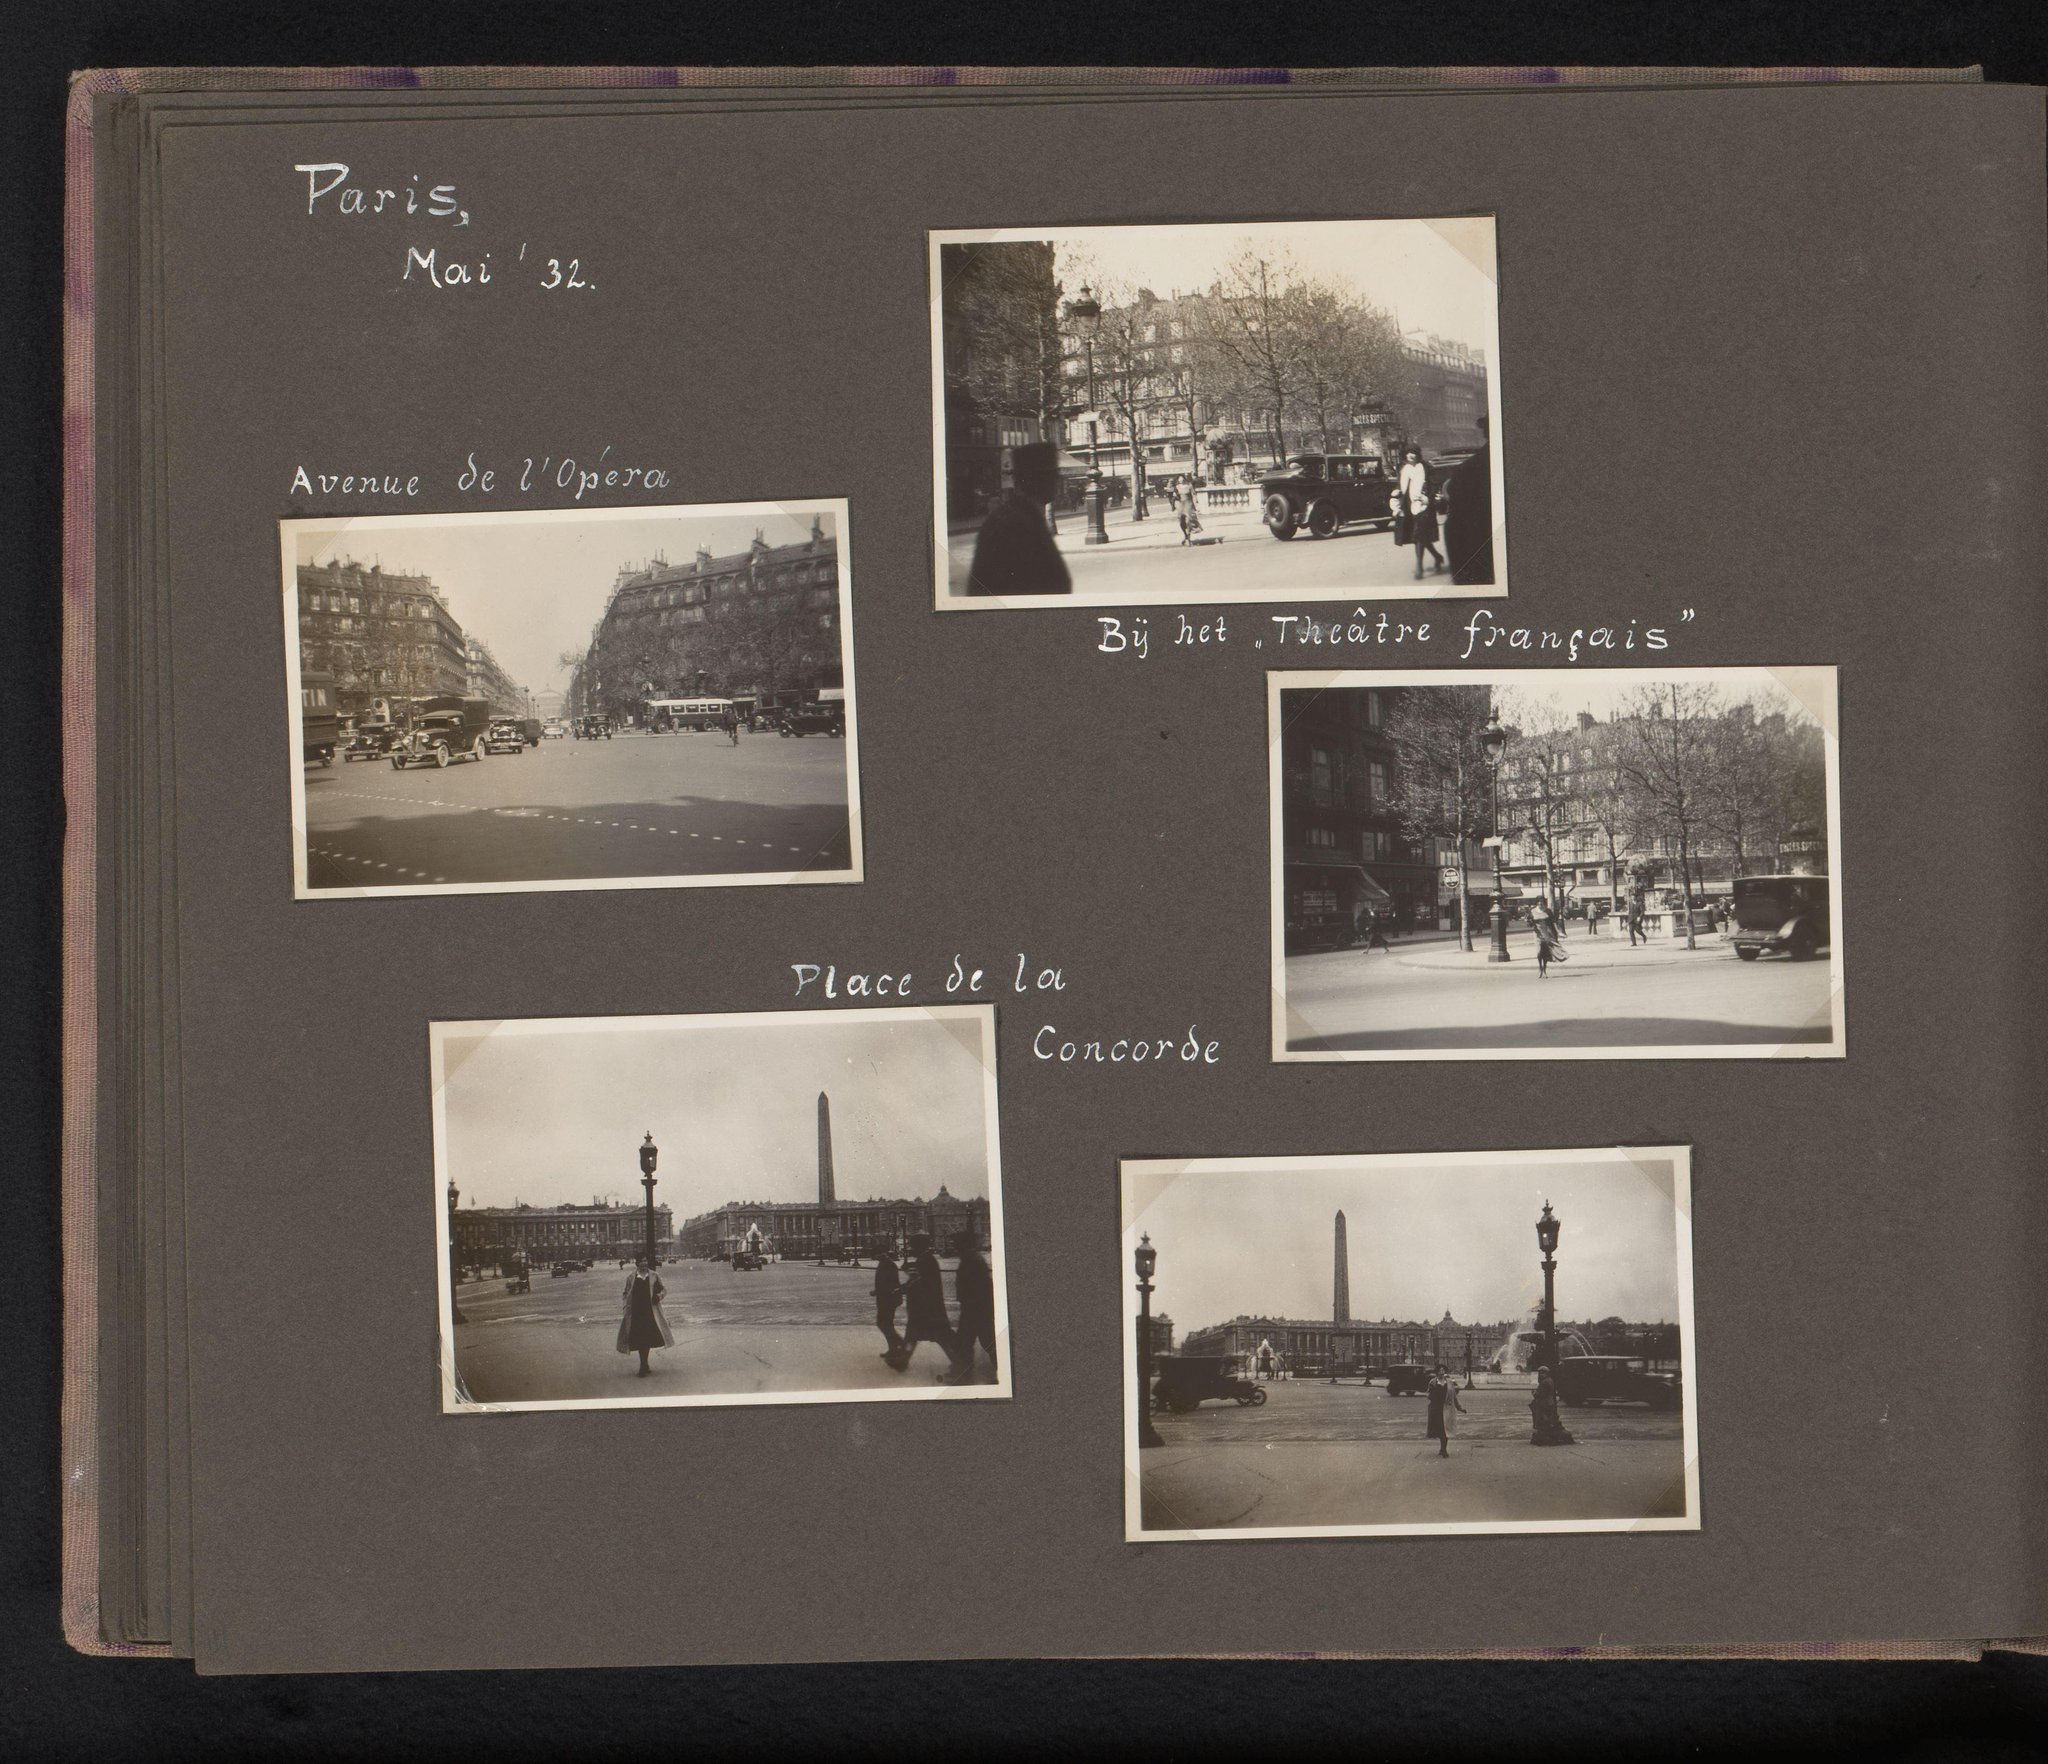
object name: album leaf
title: Bezoek aan Parijs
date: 1905-1932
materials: cardboard, paper, photographic support, plastic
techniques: gelatin silver print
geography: paris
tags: obelisk, needle, square, place, circus, etc. (+ city(-scape) with figures, staffage), street (+ city(-scape) with figures, staffage), paris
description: Vijf foto's gemaakt tijdens de vakantie van Berti Hoppe en Herman Besselaar naar Parijs in mei 1932. In de bijschriften worden Place de la Concorde en Avenue de l'Opéra vermeld. Deze pagina maakt deel uit van een album.